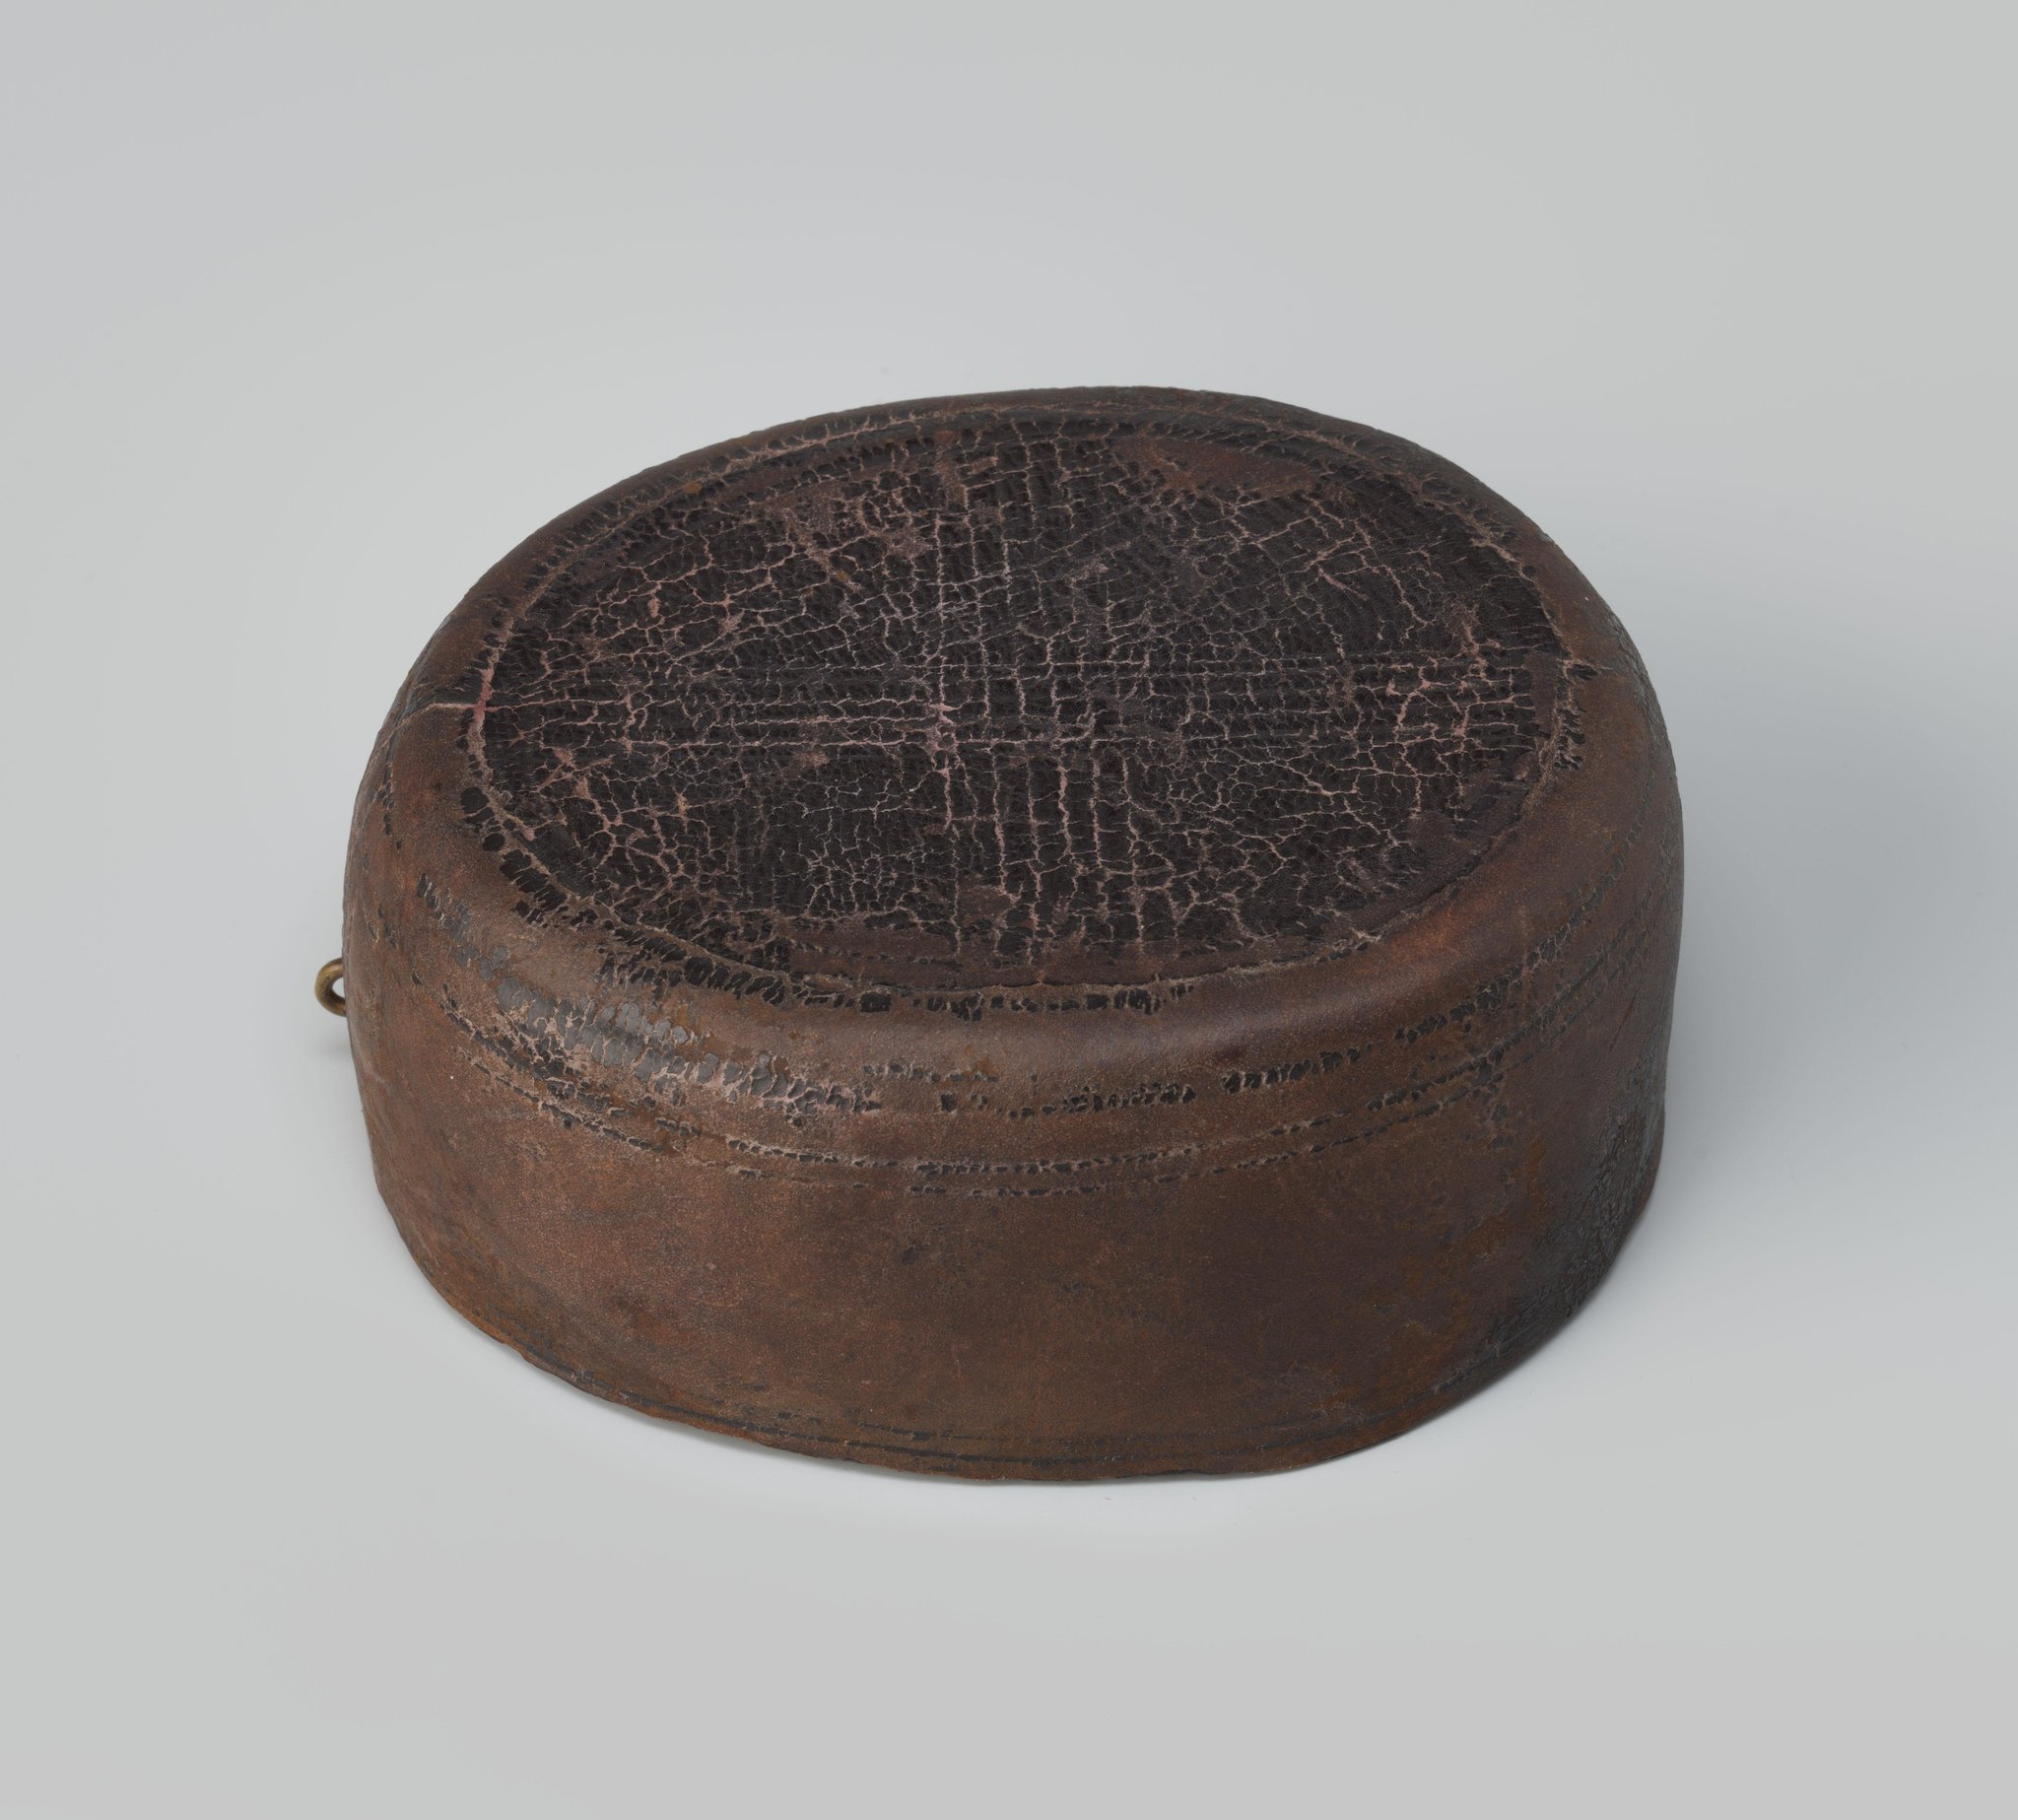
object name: case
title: Deel van leren foedraal voor goudrobijnglas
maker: Anonymous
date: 1600-1700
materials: leather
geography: europe